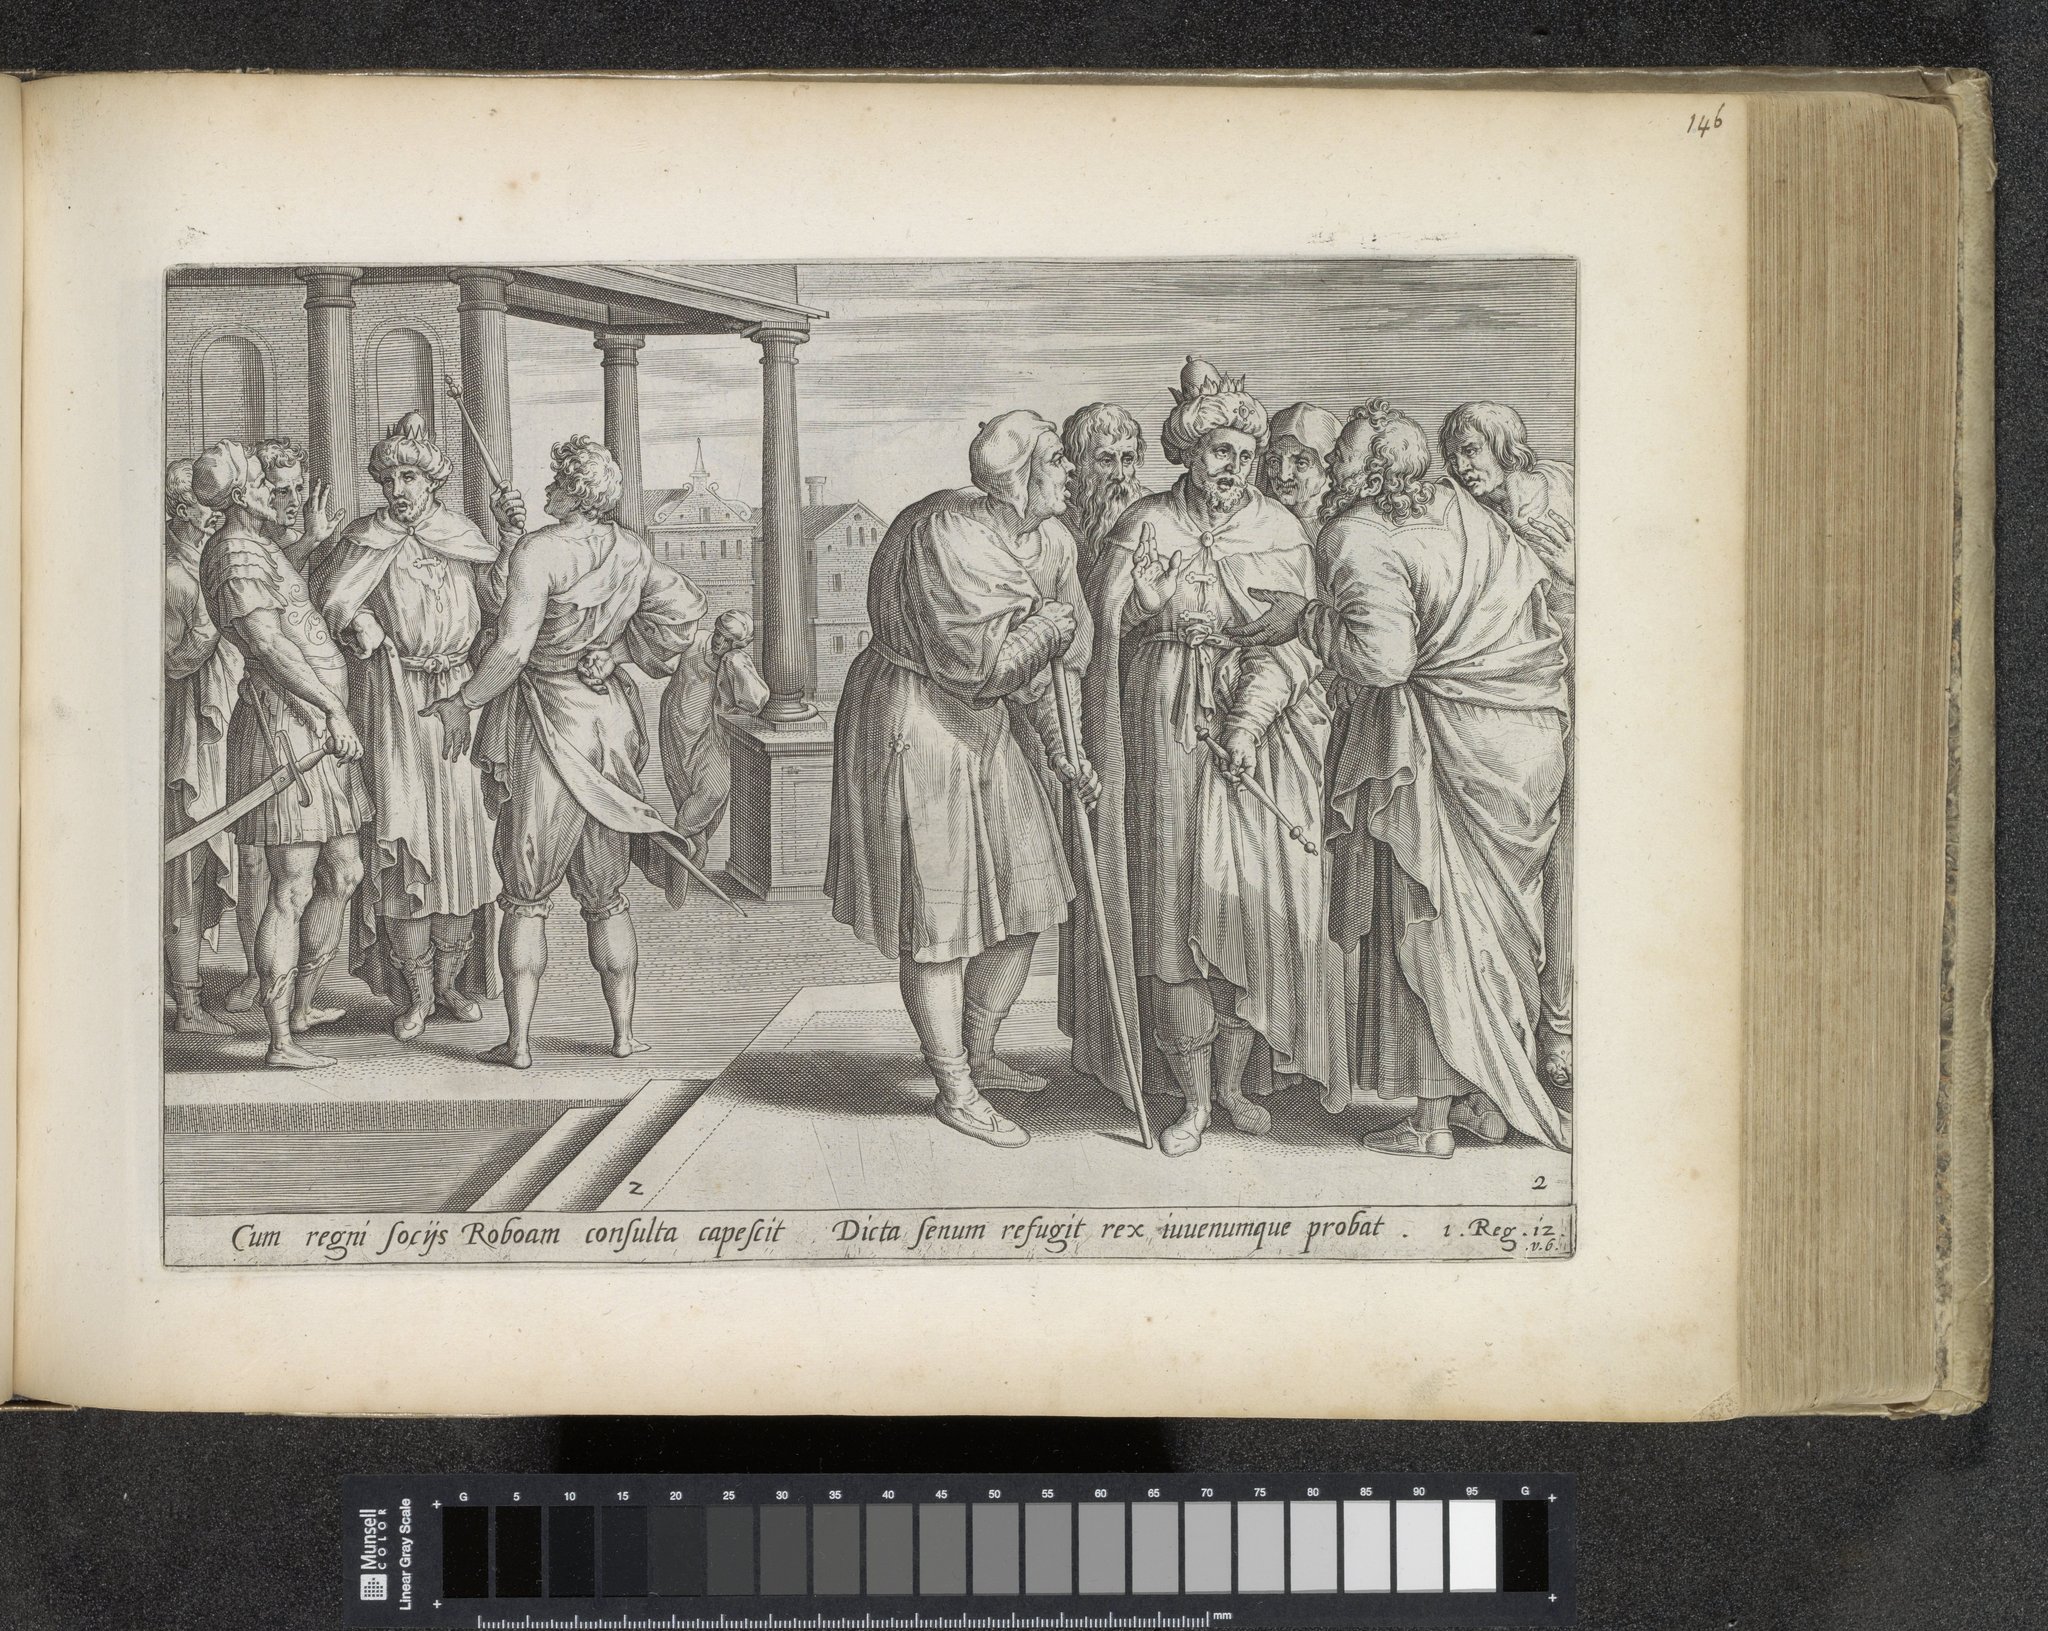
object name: album leaf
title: Rechabeam raadpleegt de oudsten en de jongemannen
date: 1579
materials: paper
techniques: engraving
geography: amsterdam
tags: rehoboam consults the young men, rehoboam taking counsel: he first consults the old men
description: Koning Rechabeam raadpleegt de oudsten die zijn vader Salomo nog hadden bijgestaan, nadat de Israëlieten hem hebben gevraagd hun juk te verlichten. De oudsten raden hem aan om het volk welwillend te zijn, maar Rechabeam negeert hun advies. Links op de achtergrond raadpleegt hij vervolgens de jongemannen met wie hij is opgegroeid. Zij raden hem aan om het verzoek van het volk niet tegemoet te komen en hun juk te verzwaren. Onder de voorstelling een verwijzing in het Latijn naar de Bijbeltekst in 1 Kon. 12:6. Deze prent maakt deel uit van een album.